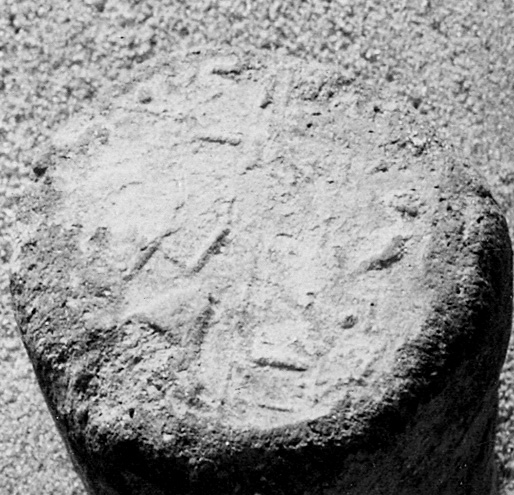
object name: cone, circular impression, amenhotep, scribe, amun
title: Funerary Cone of the Scribe Amenhotep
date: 1550-1295 BCE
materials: pottery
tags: hieroglyphs